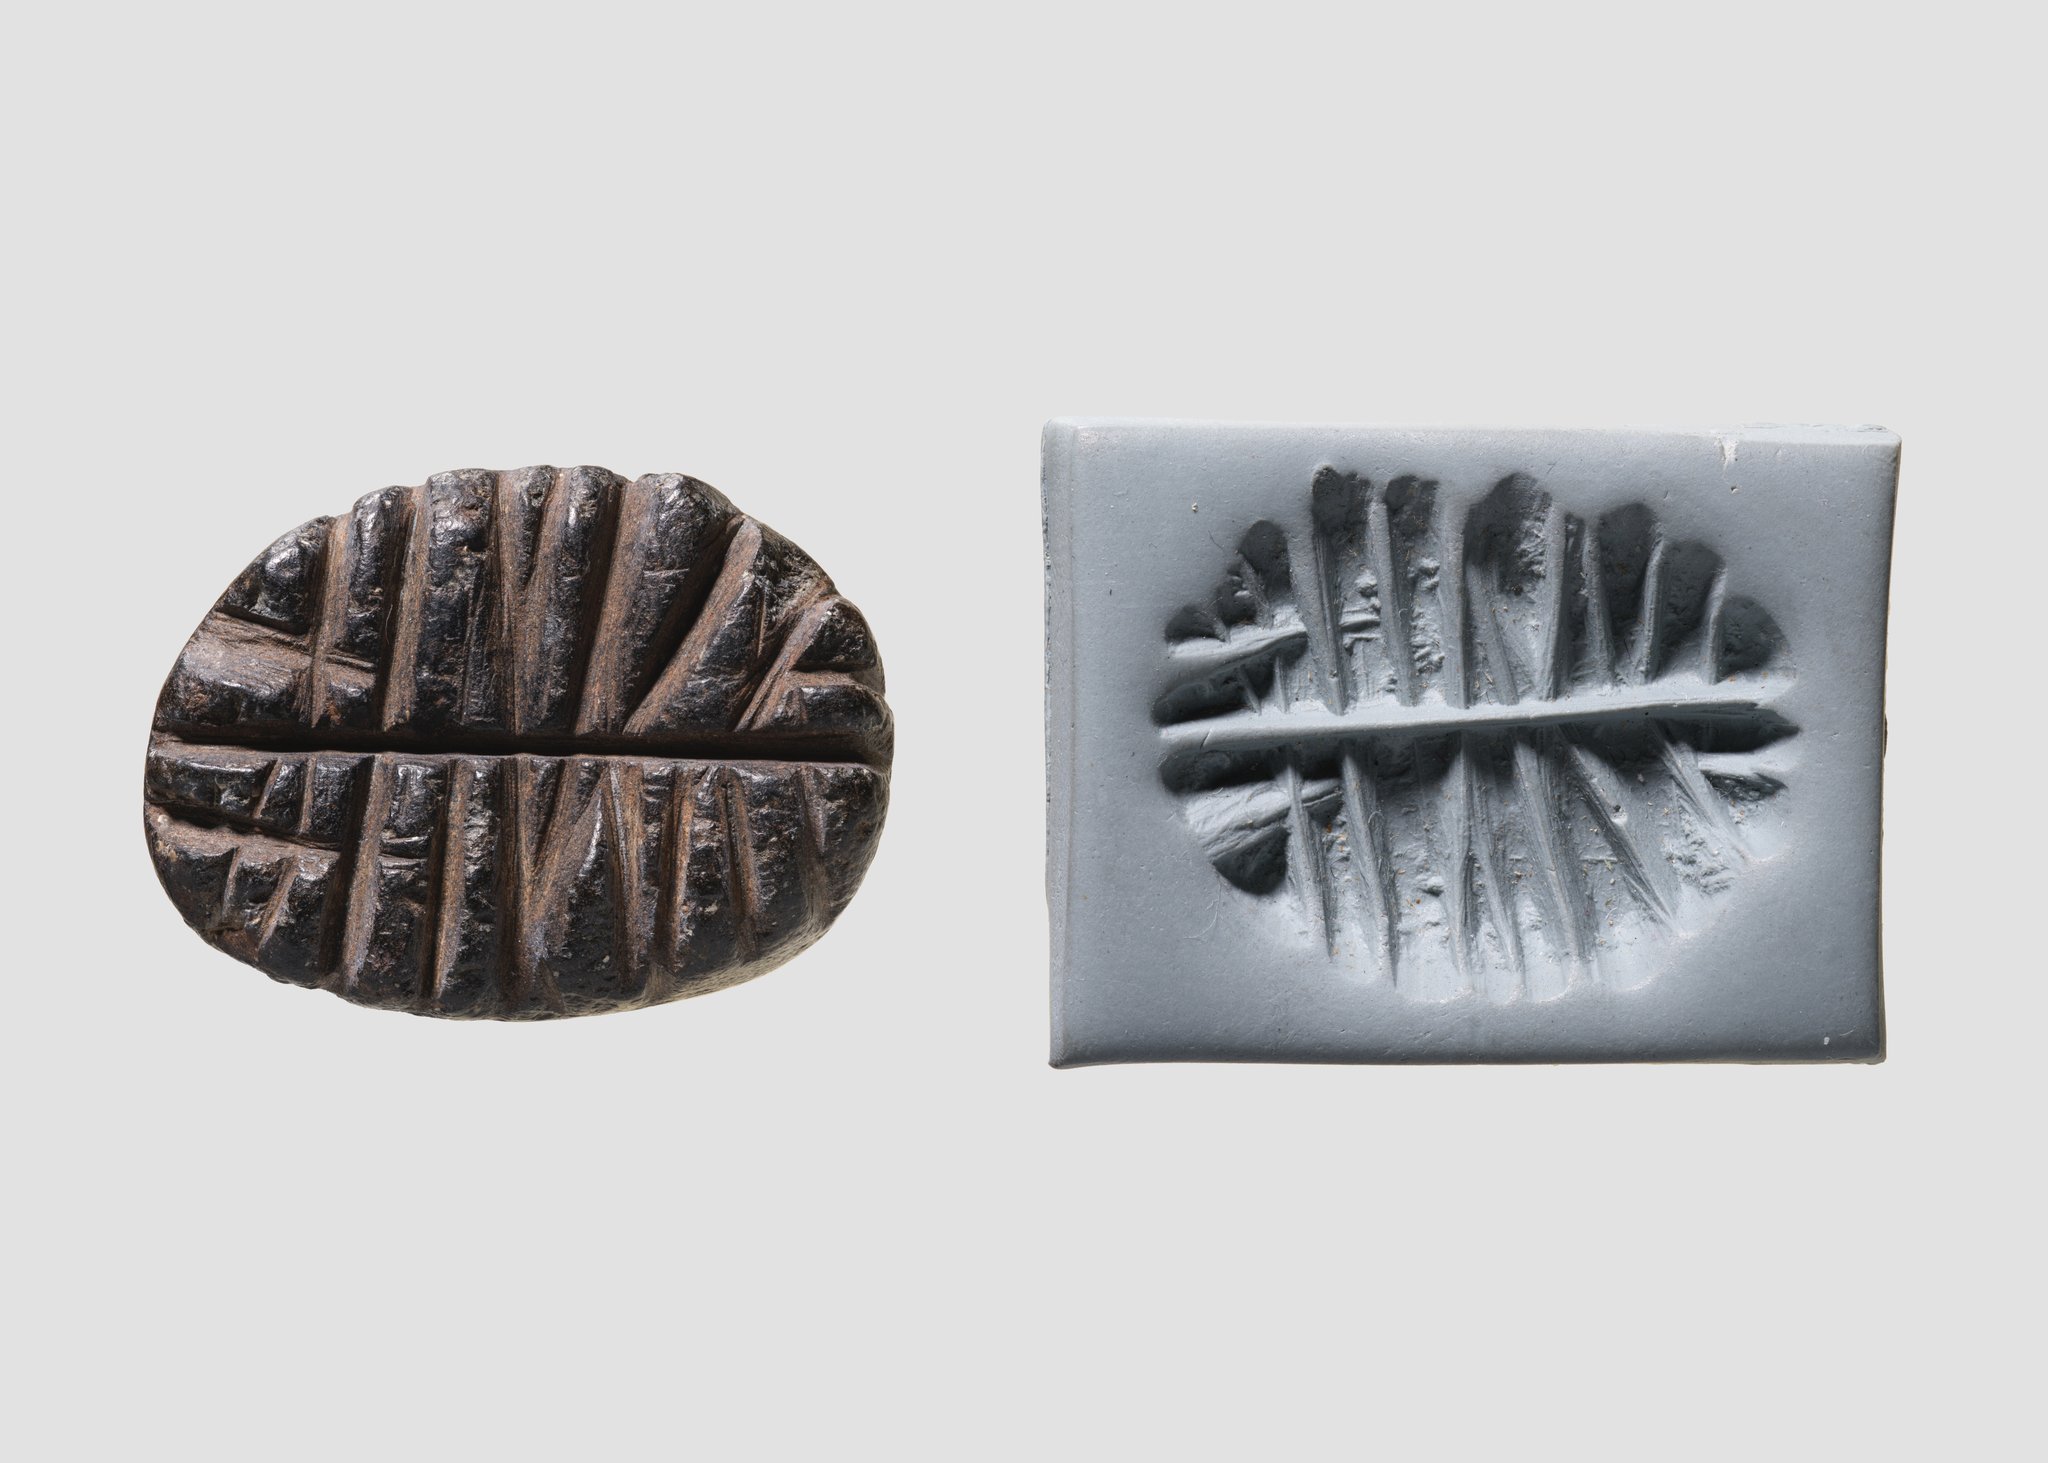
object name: stamp seal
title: Pyramidal stamping device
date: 7000-5001 BCE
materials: mineral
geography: northern syria or northern mesopotamia